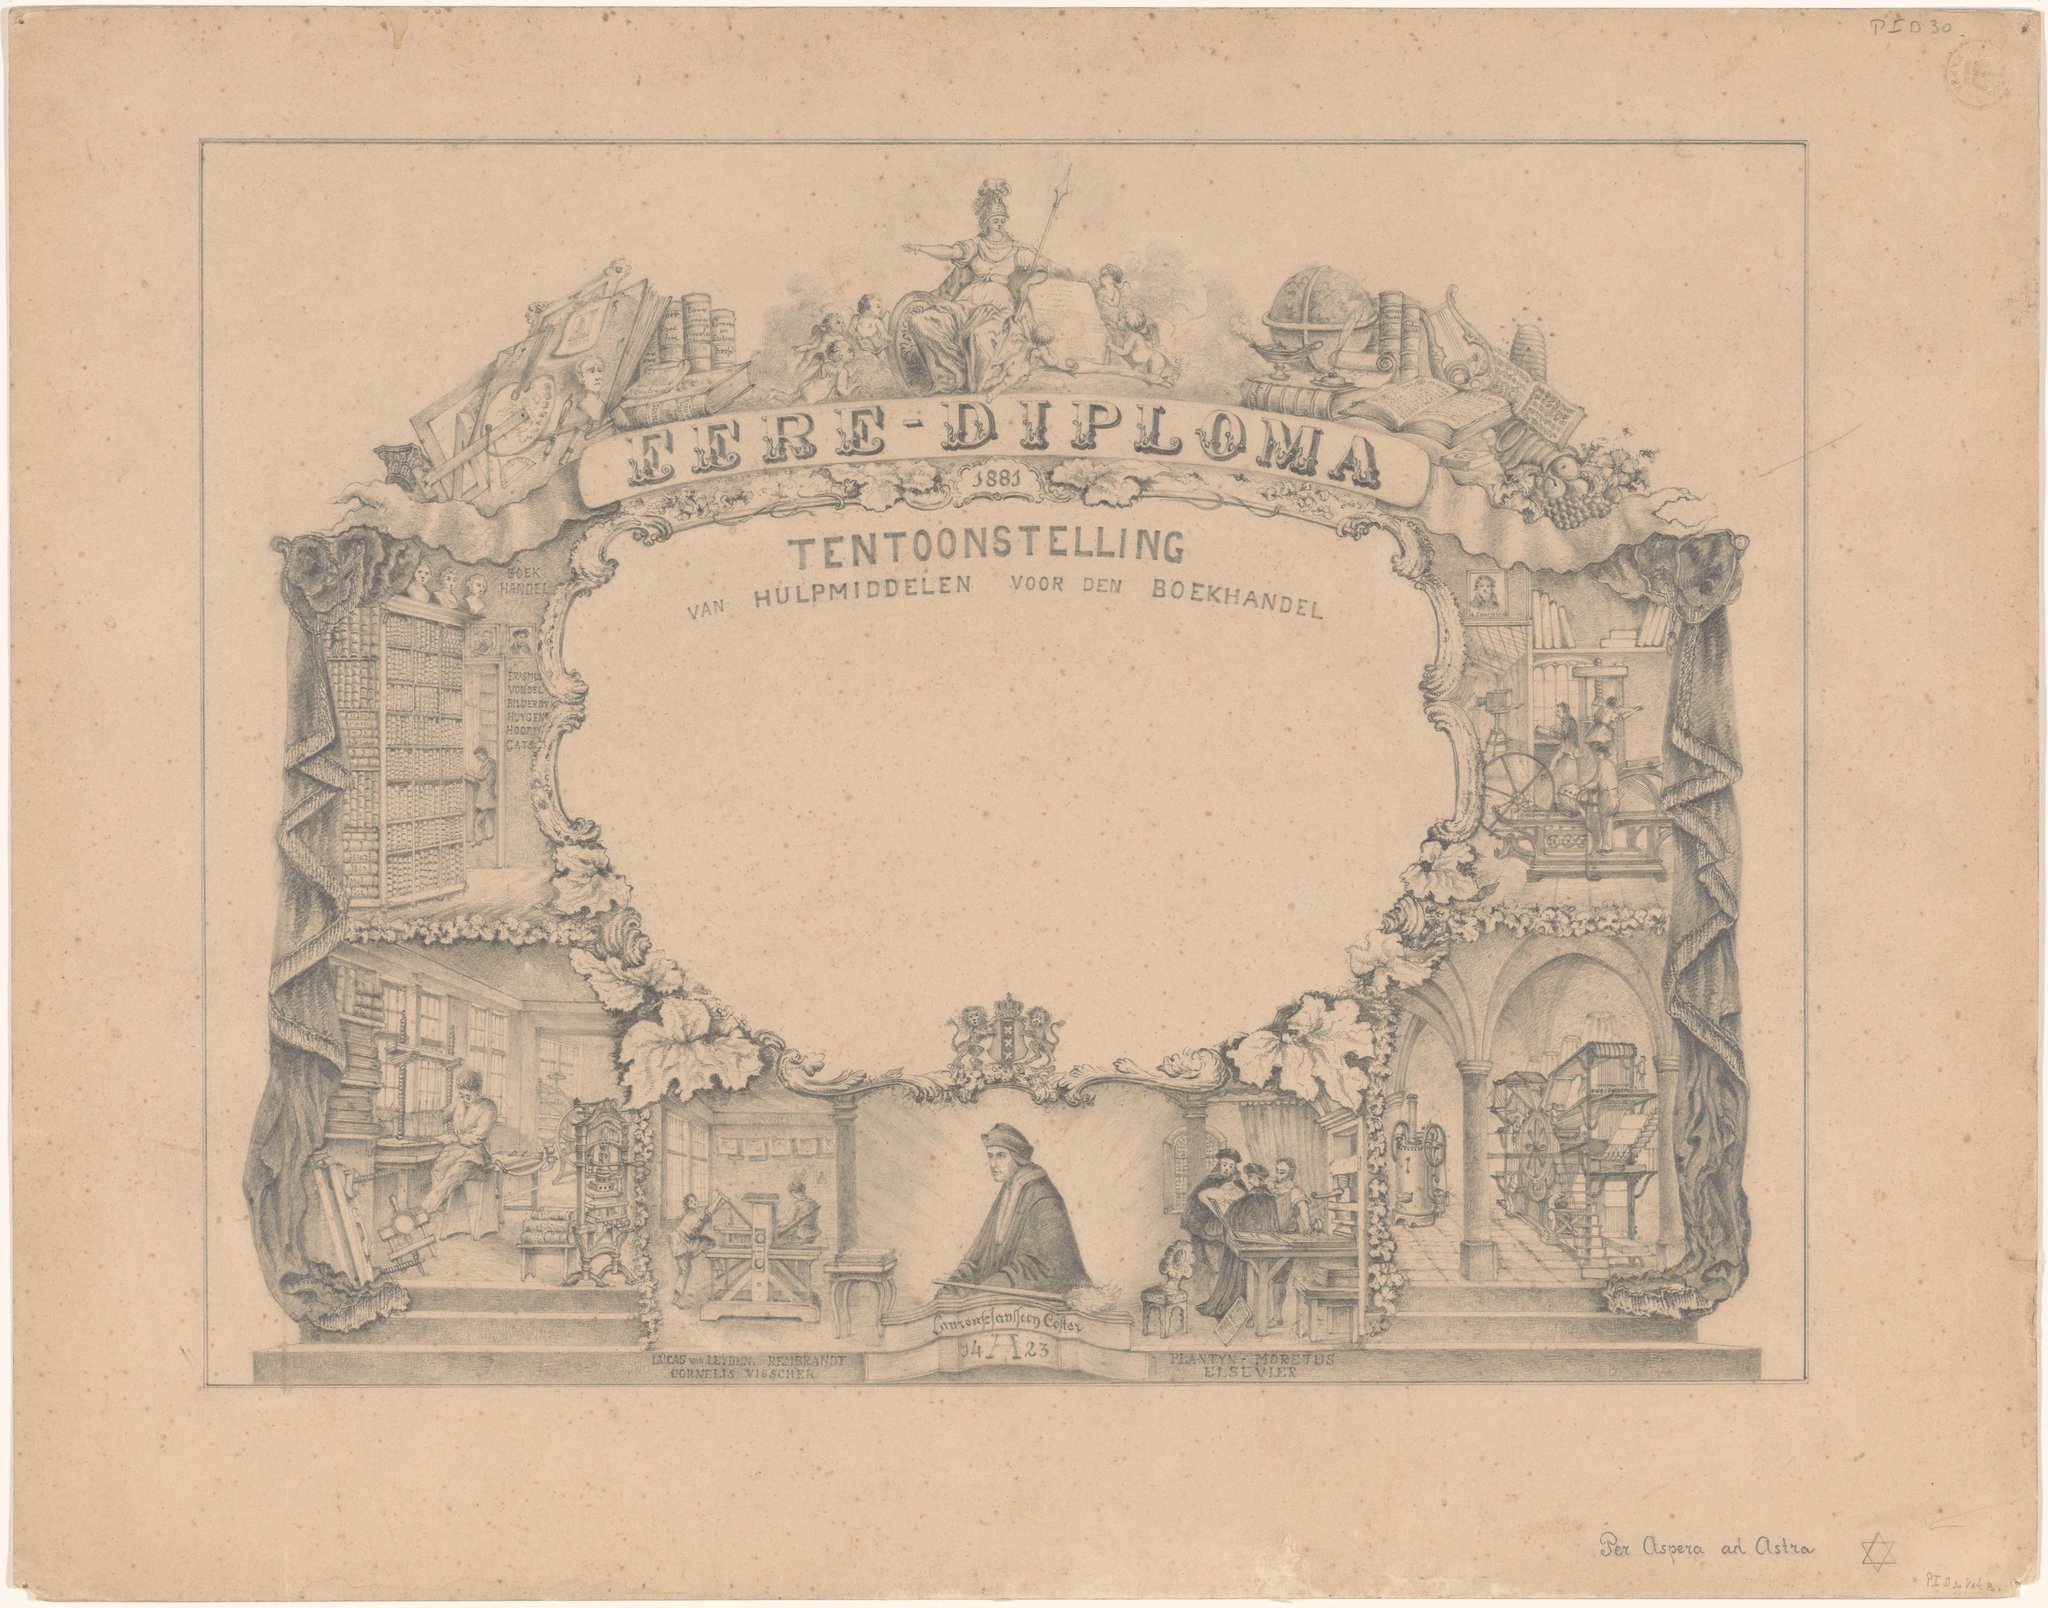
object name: drawing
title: Eere-diploma tentoonstelling van hulpmiddelen voor den boekhandel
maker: Anonymous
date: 1881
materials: paper, pencil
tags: haarlem, bookbinding, printing press, tools, implements of graphic artist, specific aspects, allegorical aspects of minerva; minerva as patroness, cupids: 'amores', 'amoretti', 'putti', book-shop, bookseller, amsterdam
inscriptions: inscription: ‘Per Aspera ad Astra’, check stamp: ‘Bristol Paper’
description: Decoratieve omlijsting met boven Minerva omringd door putti met aan weerszijden een stilleven bestaand uit boeken en andere objecten. Links en rechts de interieurs van een boekhandelaar, een handboekbinder, een steendrukkerij en een moderne boekbinderij. Onder het portret van Laurens Janszoon Coster met links een plaatdrukkerij en rechts een boekdrukkerij. Boven Coster het wapen van Amsterdam.